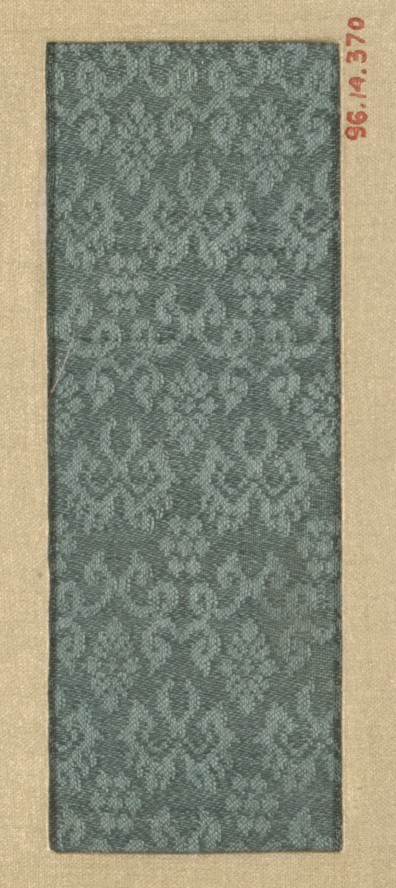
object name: piece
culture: japanese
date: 1701-1900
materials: silk